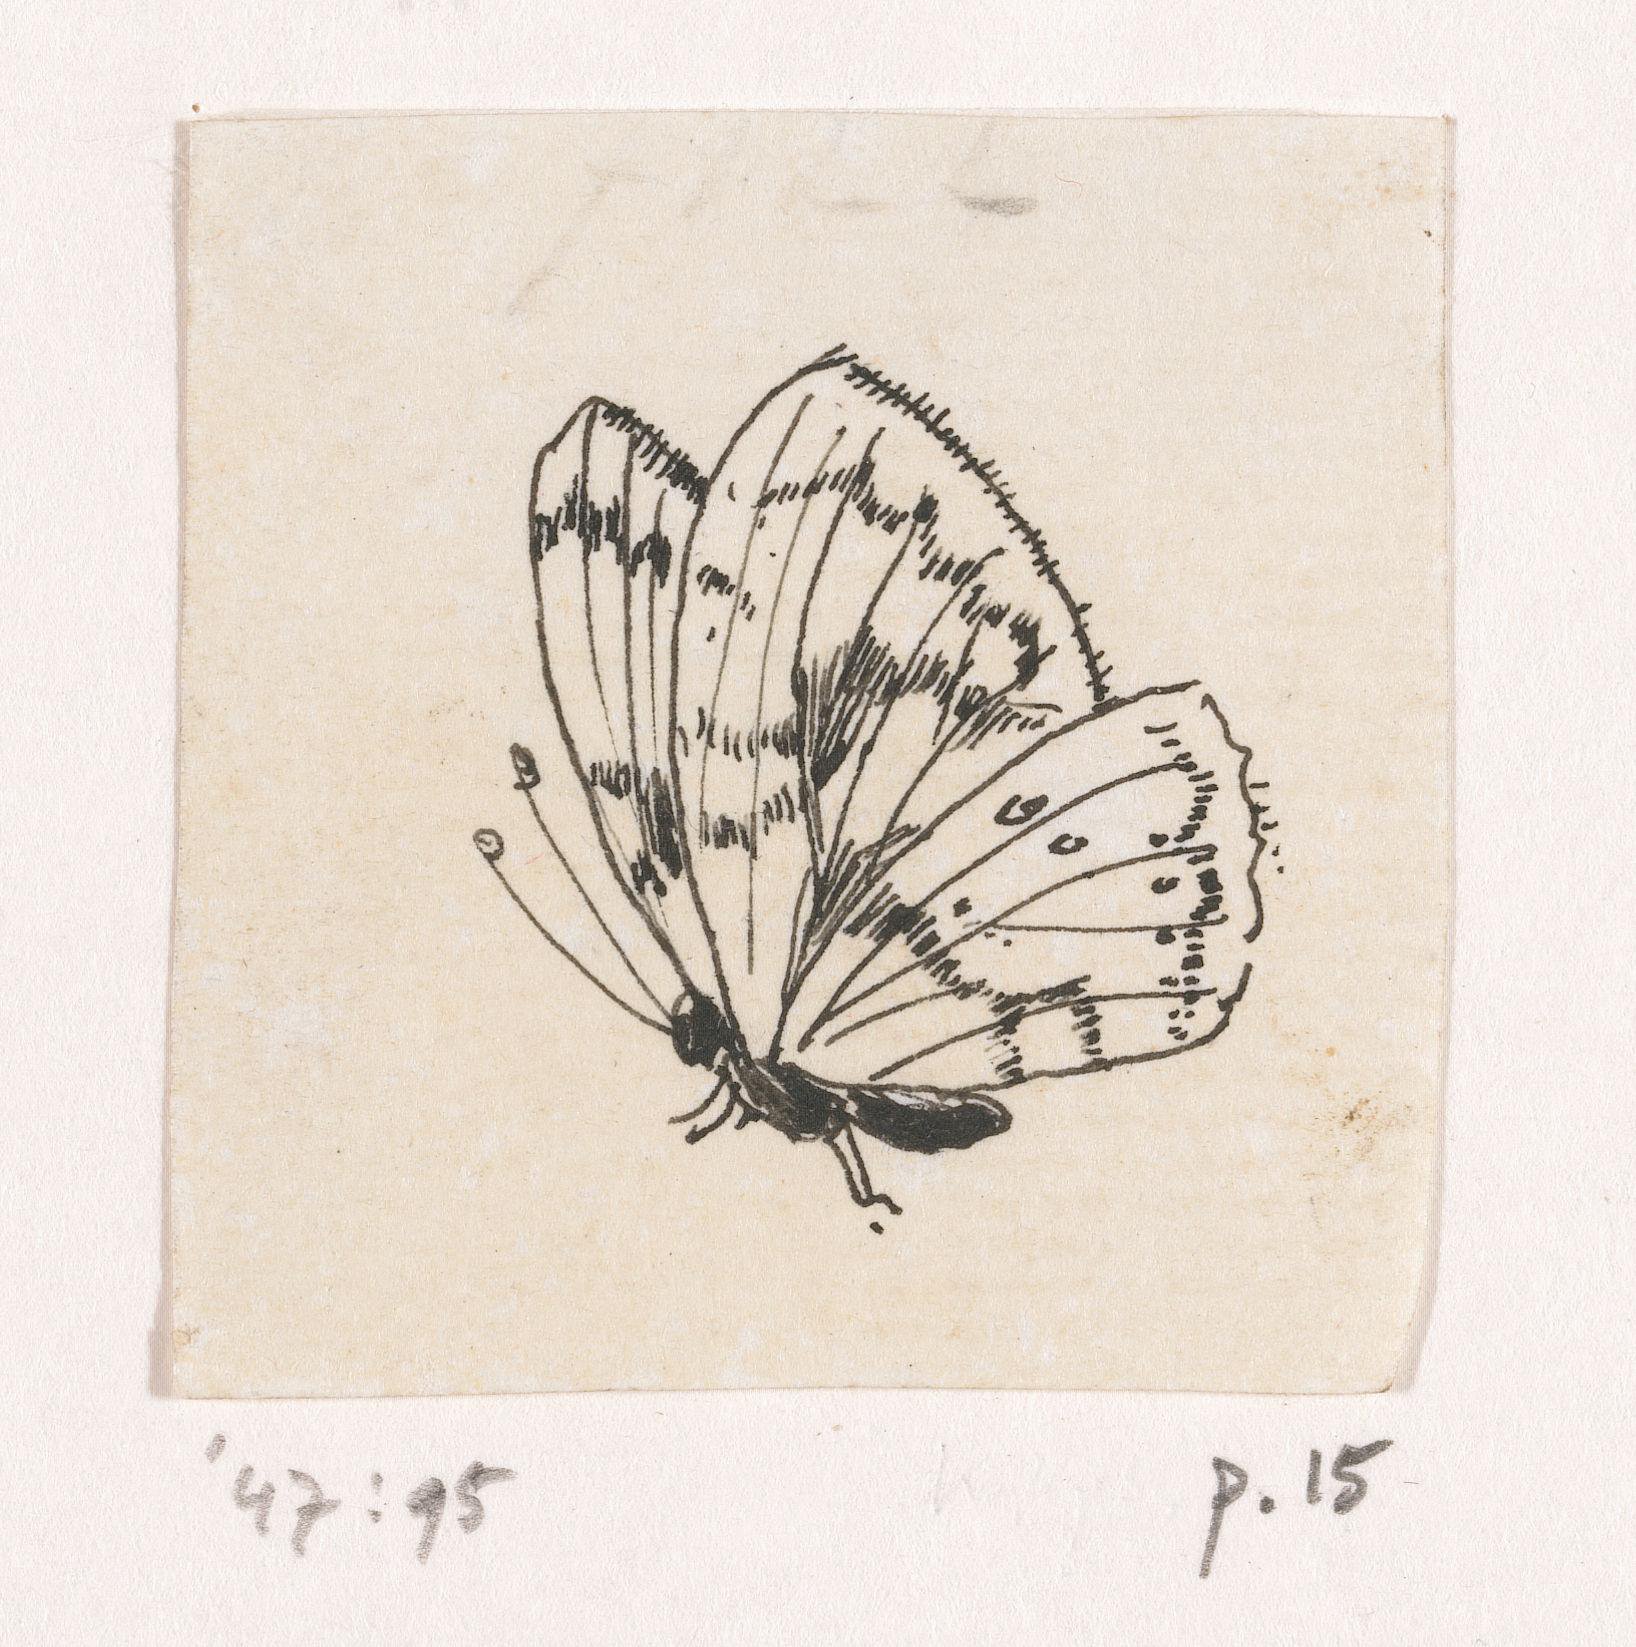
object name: boekillustratie ontwerp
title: Witje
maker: willem wenckebach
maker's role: designer, draughtsman, painter, print maker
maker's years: 1860-1937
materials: ink, paper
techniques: pen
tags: insects: butterfly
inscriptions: collector's mark: Lugt 2228a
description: Ontwerp voor: Knappert, Emilie C. Kijkjes in de plantenwereld. Loman & Funke: Amsterdam, 1893.